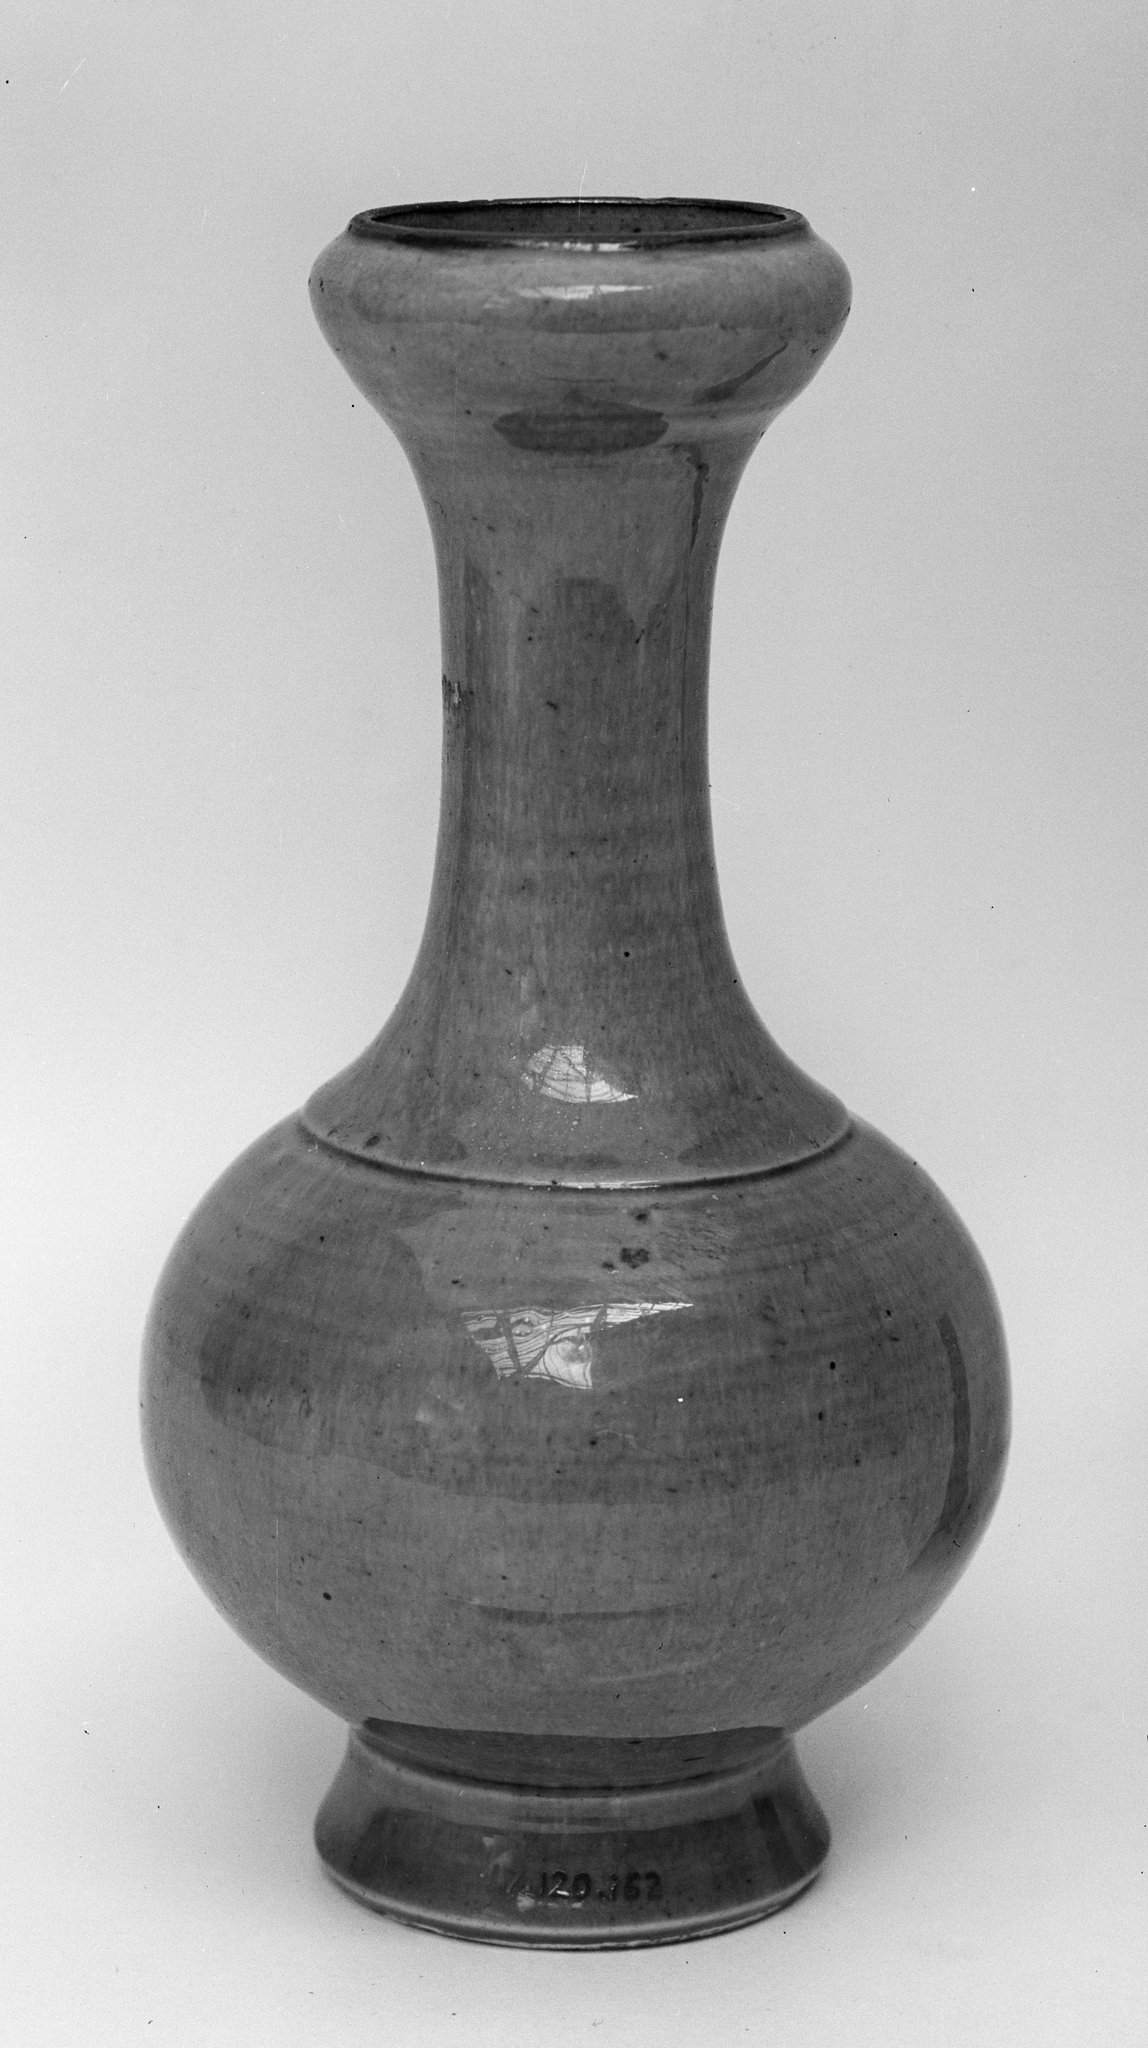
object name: vase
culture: chinese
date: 1701-1800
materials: glaze, porcelain